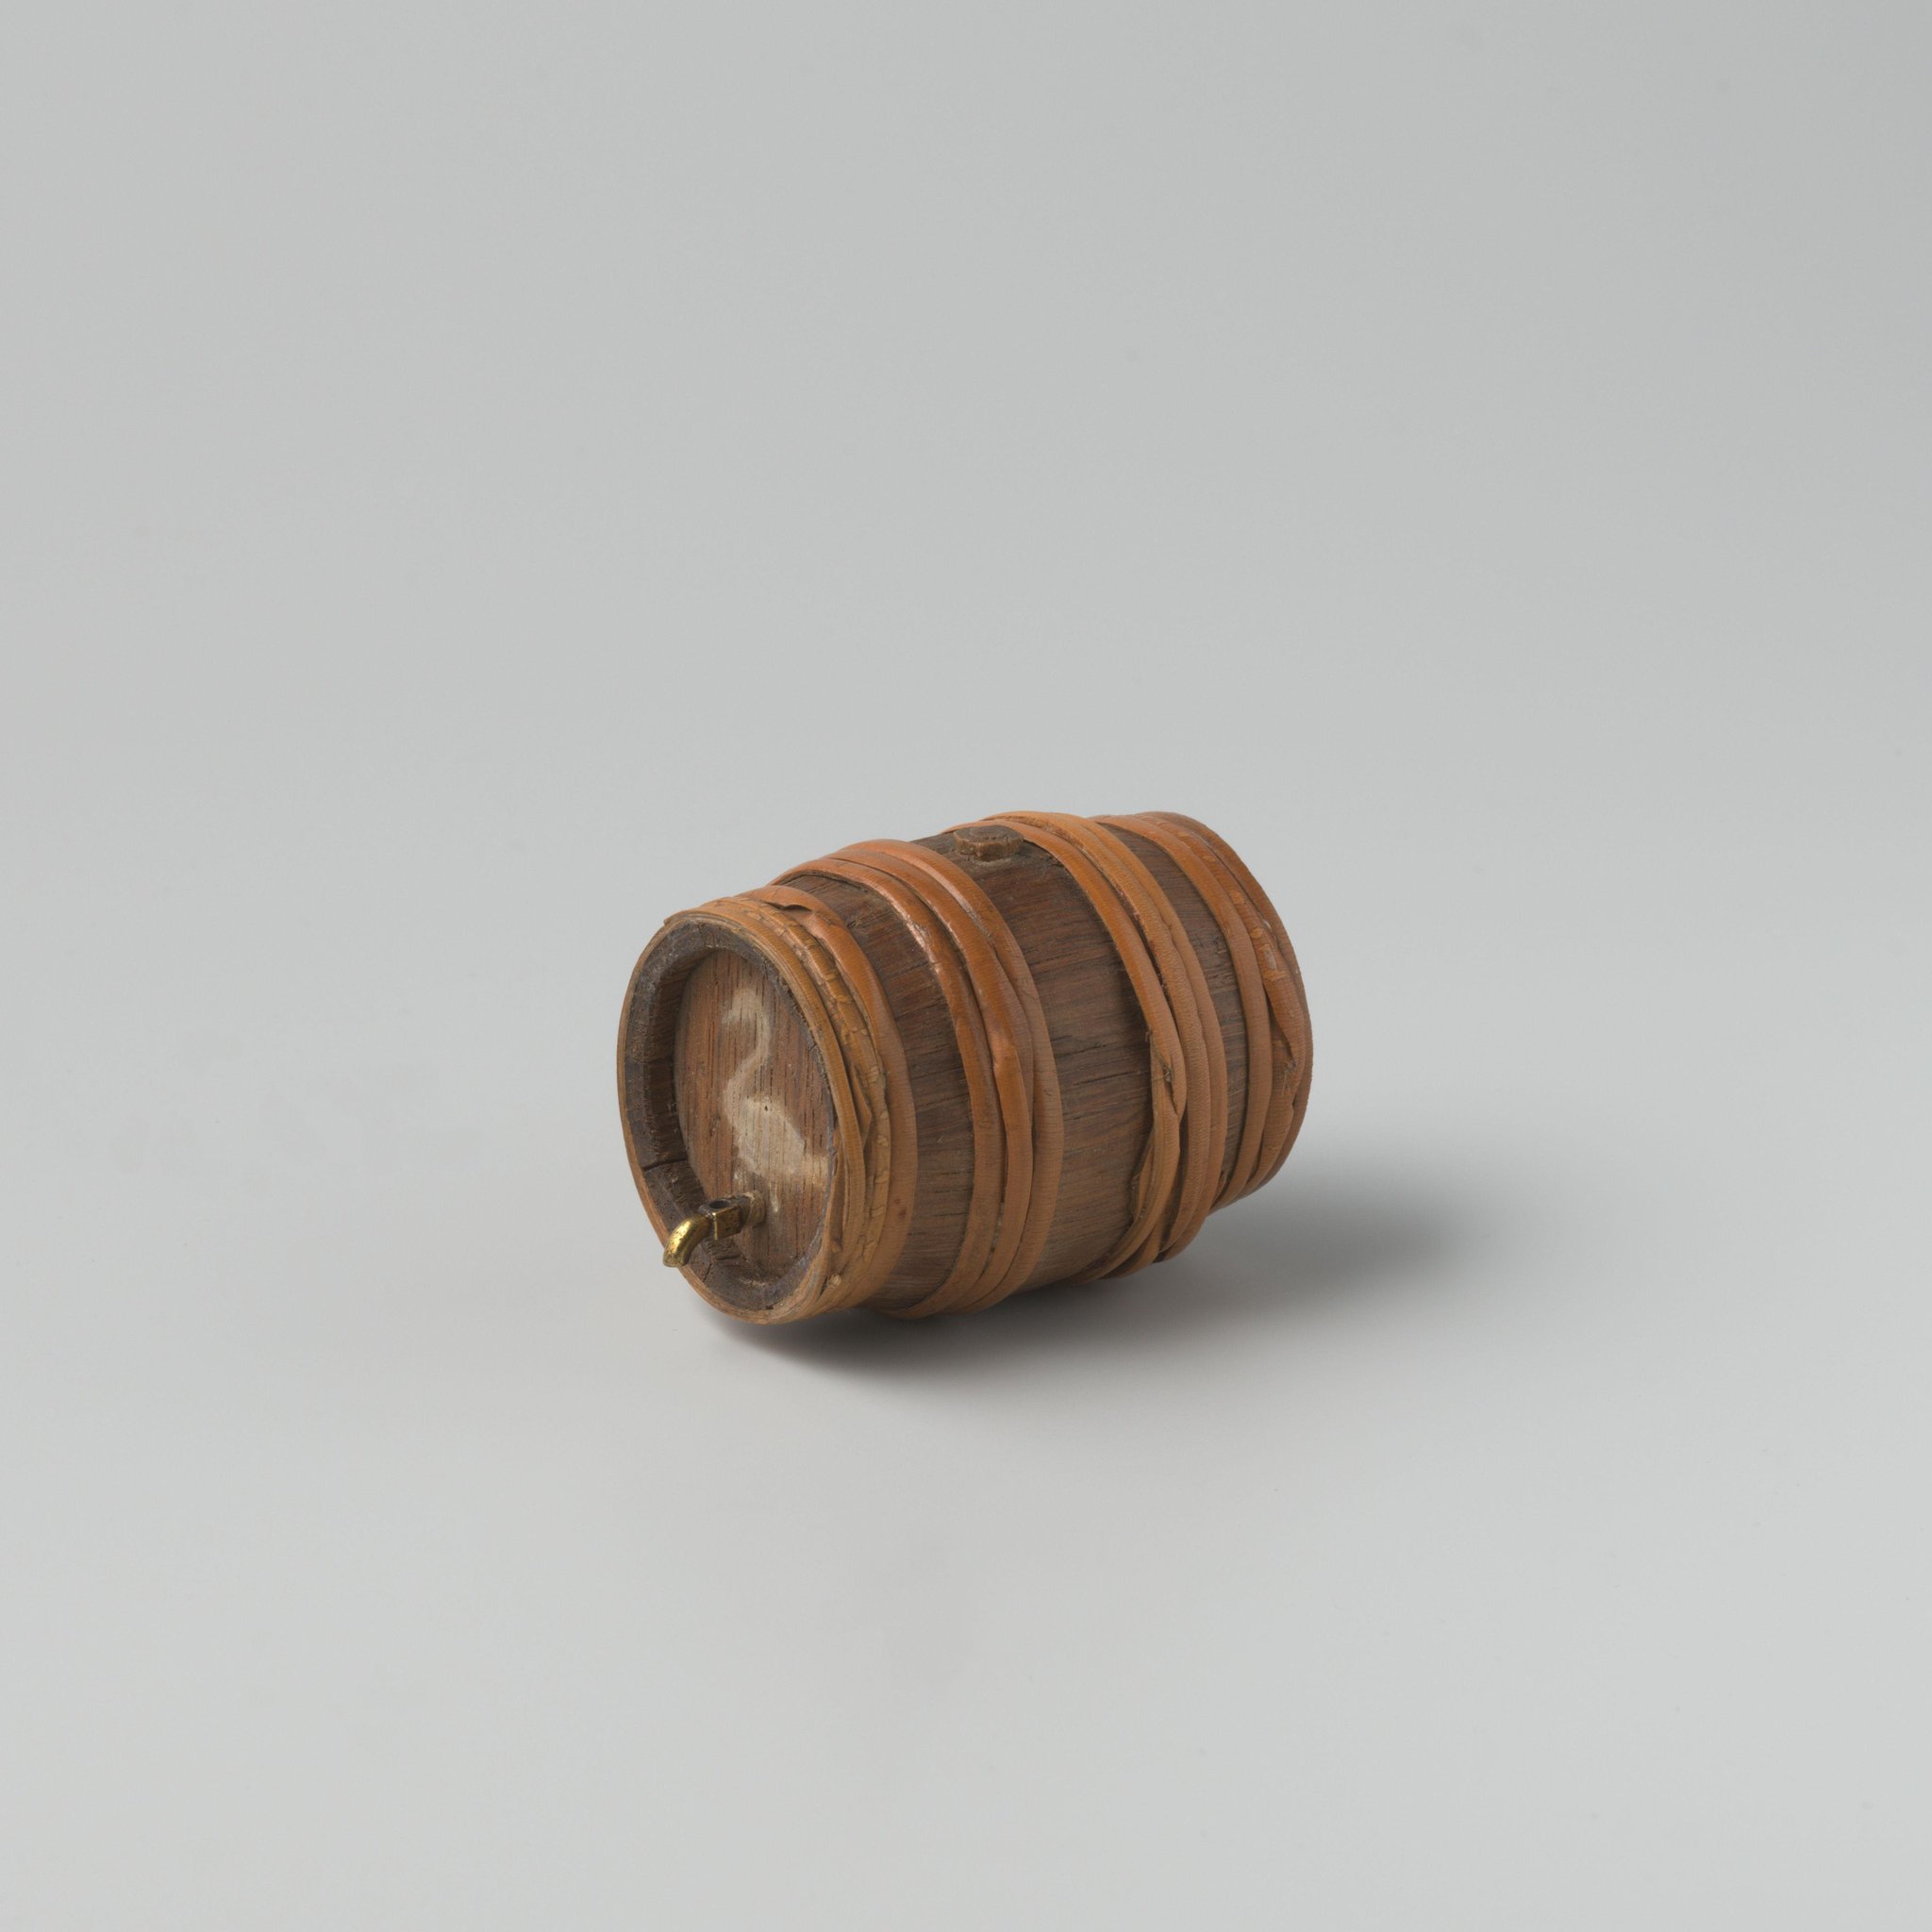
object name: vessel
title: Bier- of wijnvat, van eikenhouten duigen, omwonden door 4 x 3 hoepels van rotan, op de voorkant met witte verf een zwaantje geschilderd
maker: Anonymous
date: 1690-1710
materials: brass, wood, rattan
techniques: gilding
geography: amsterdam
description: Bier- of wijnvat, van eikenhouten duigen, omwonden door 4 x 3 hoepels, van rotan. Op de voorkant met witte verf een zwaantje geschilderd.